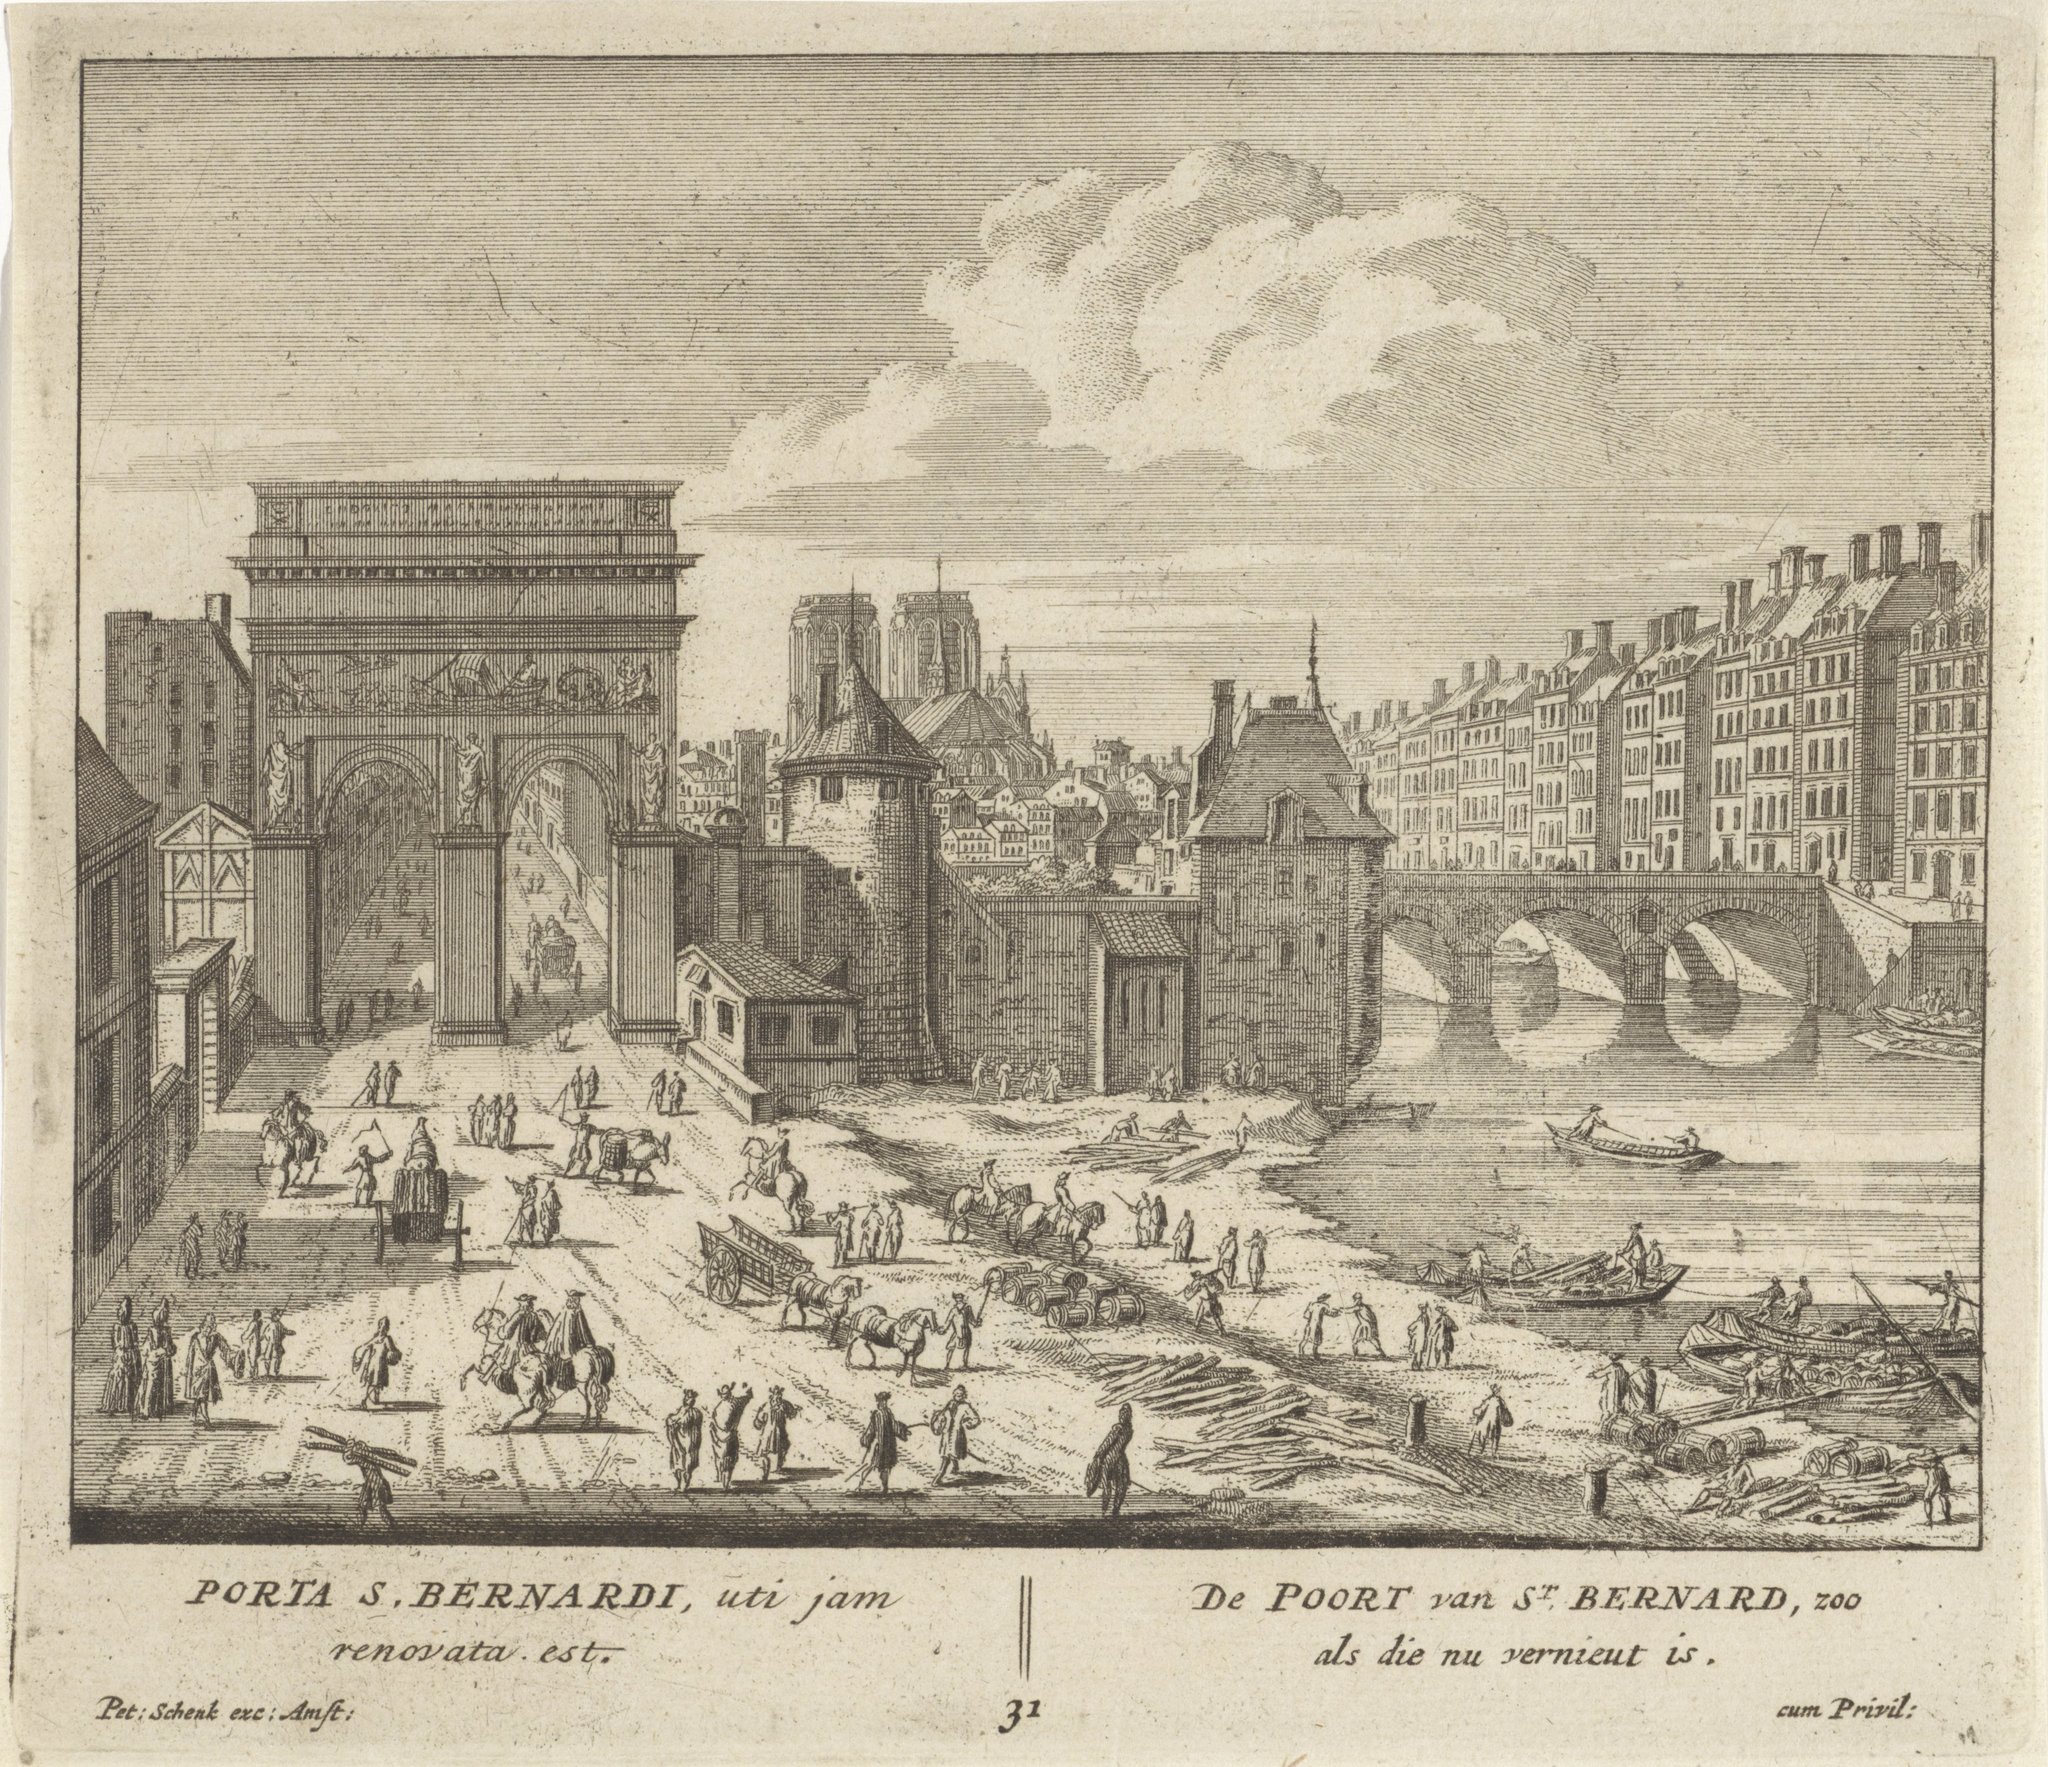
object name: print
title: De Poort van St Bernard, zoo als die nu vernieut is.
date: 1675-1711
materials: paper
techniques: etching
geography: amsterdam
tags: river, gate, entrance, paris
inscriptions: collector's mark: Lugt 2228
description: De stadspoort van St. Bernard te Parijs aan de Seine. Achter de stadsmuur een grote kerk zichtbaar.